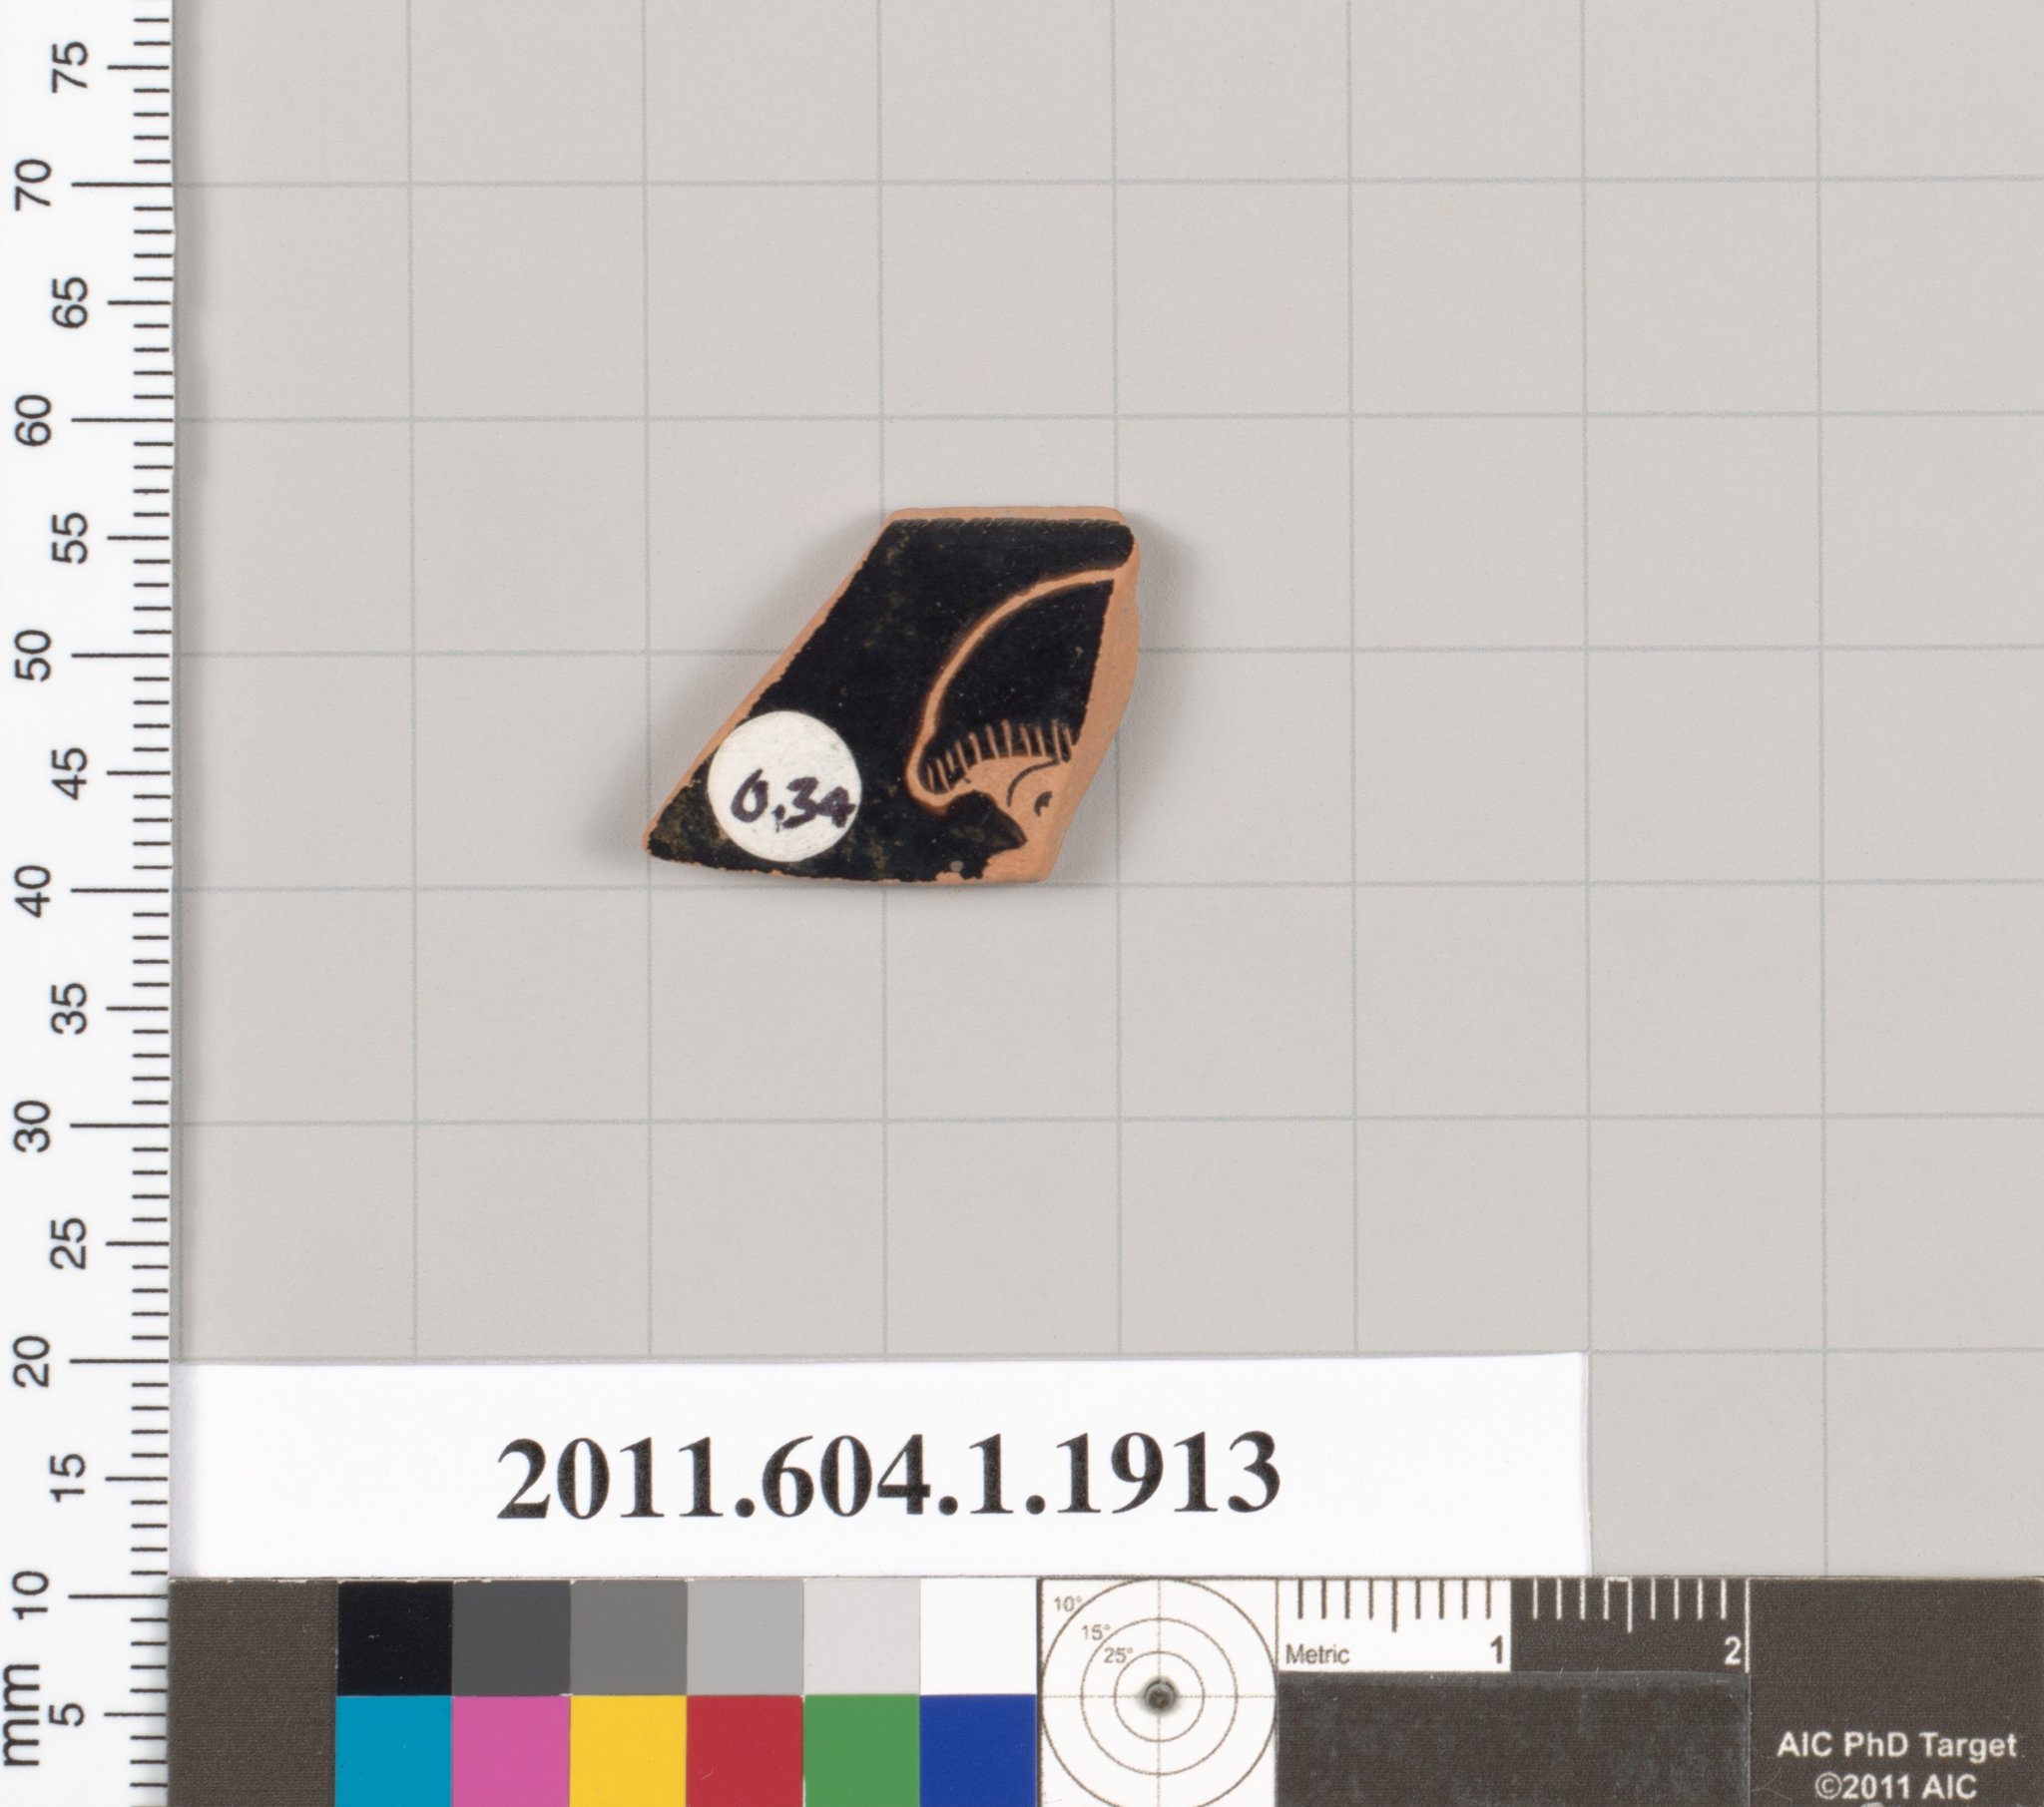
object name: kylix fragment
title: Terracotta rim fragment of a kylix (drinking cup)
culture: greek, attic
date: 534-501 BCE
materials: terracotta